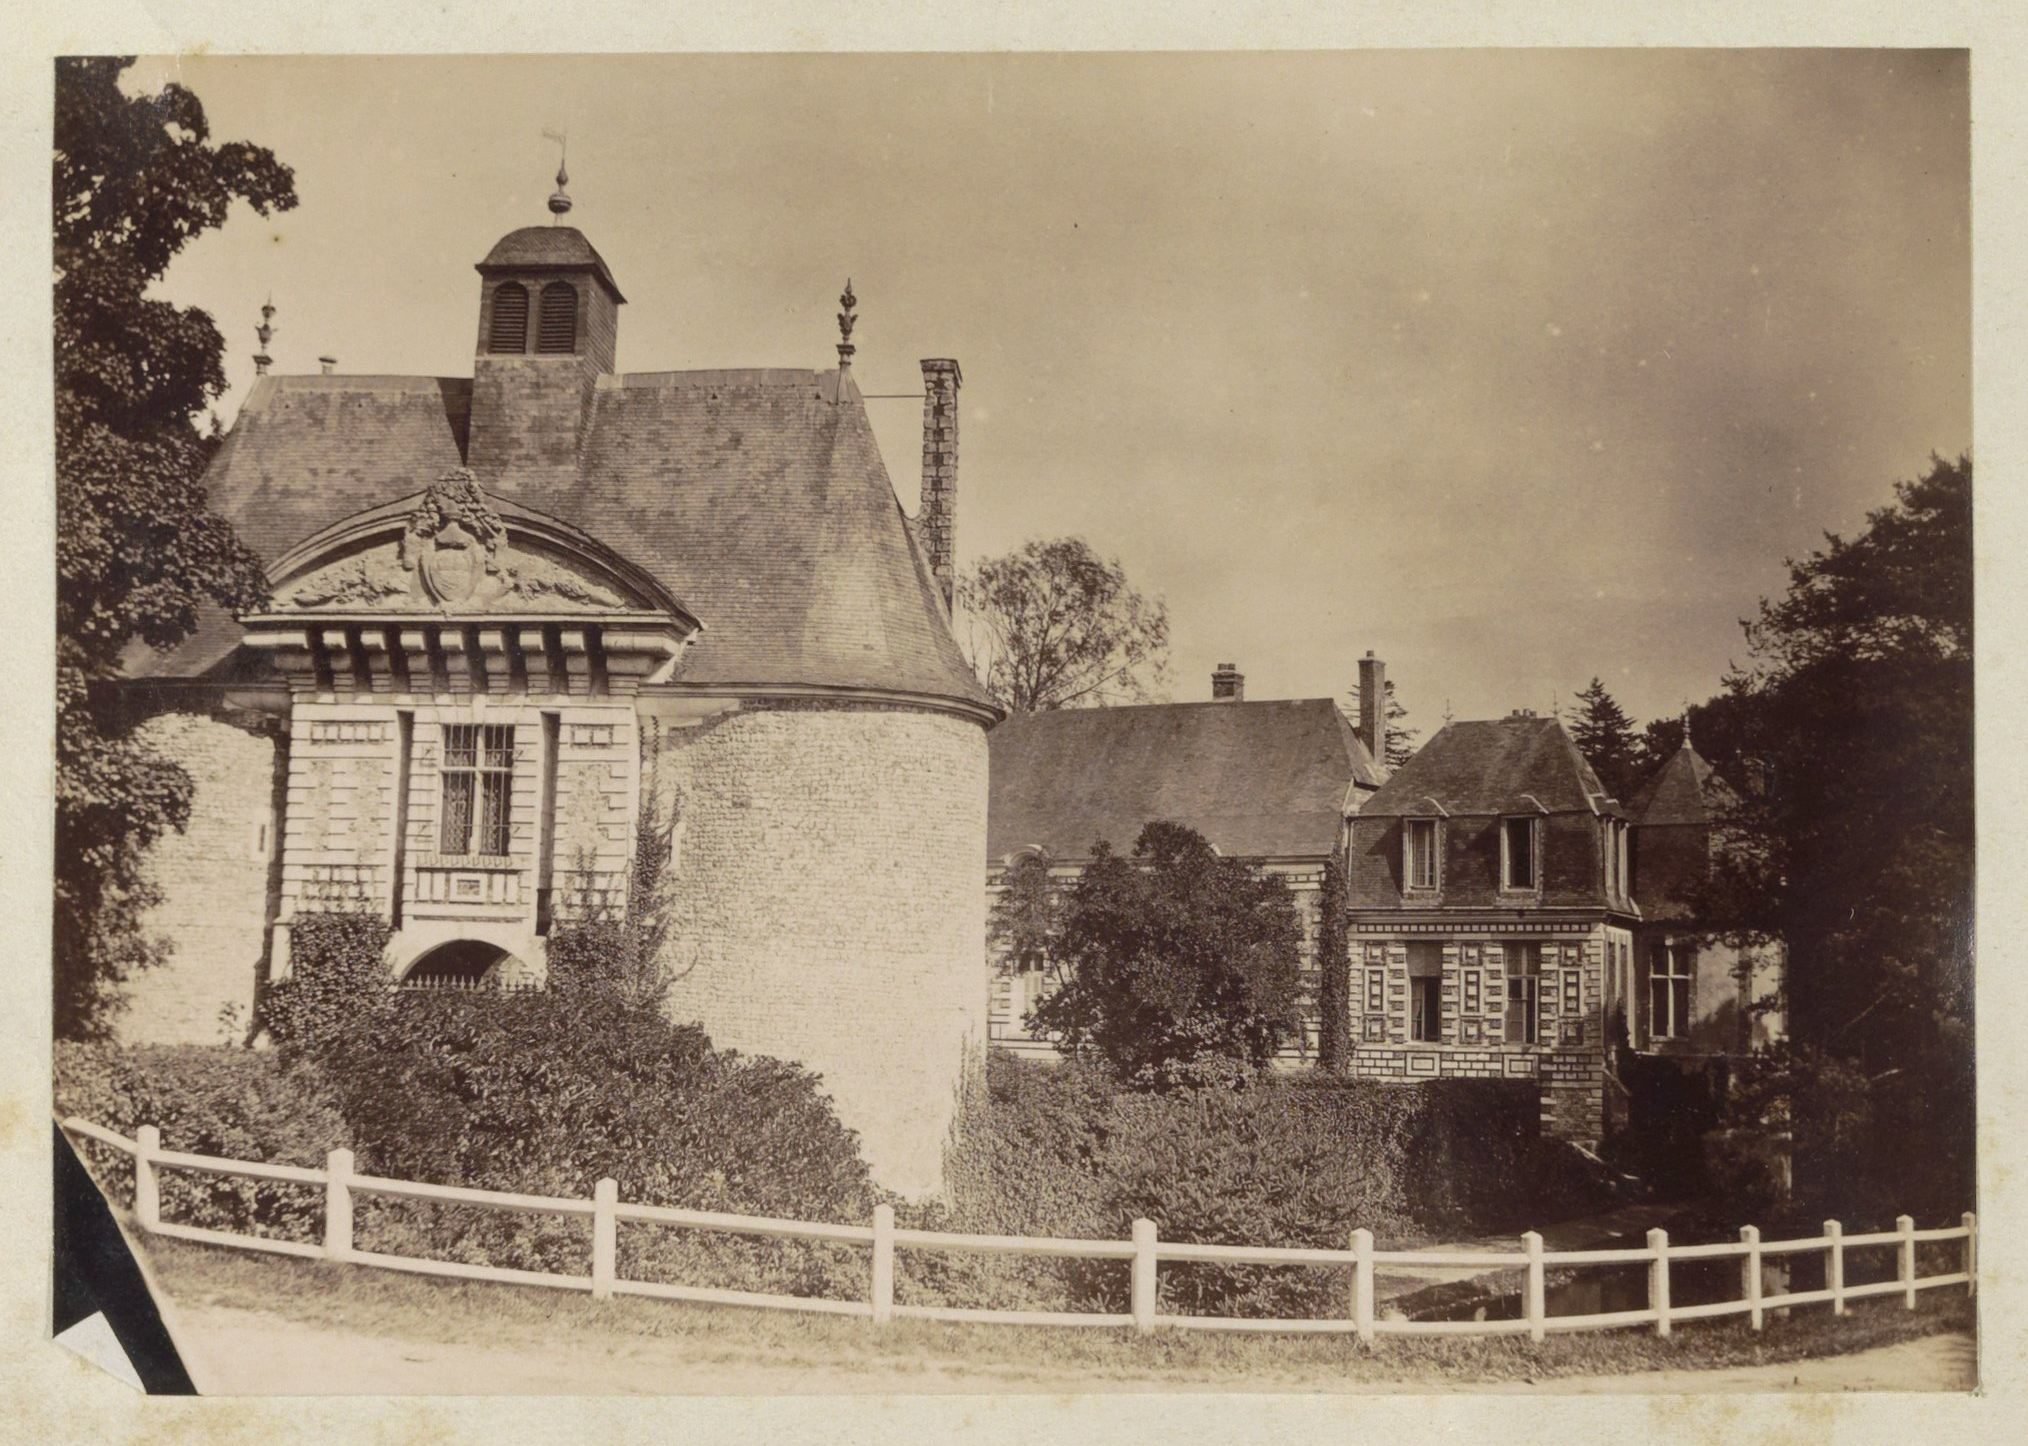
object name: photograph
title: Landhuis en poortgebouw met fronton in Frankrijk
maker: Anonymous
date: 1807-1884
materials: photographic support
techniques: albumen print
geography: france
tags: castle, rural housing, e.g. country-house, villa, cottage, gate, entrance, france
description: Onderdeel van Album van een Franse amateurfotograaf met opnames van familie, militairen, industrie, landschappen en bezienswaardigheden in Frankrijk.